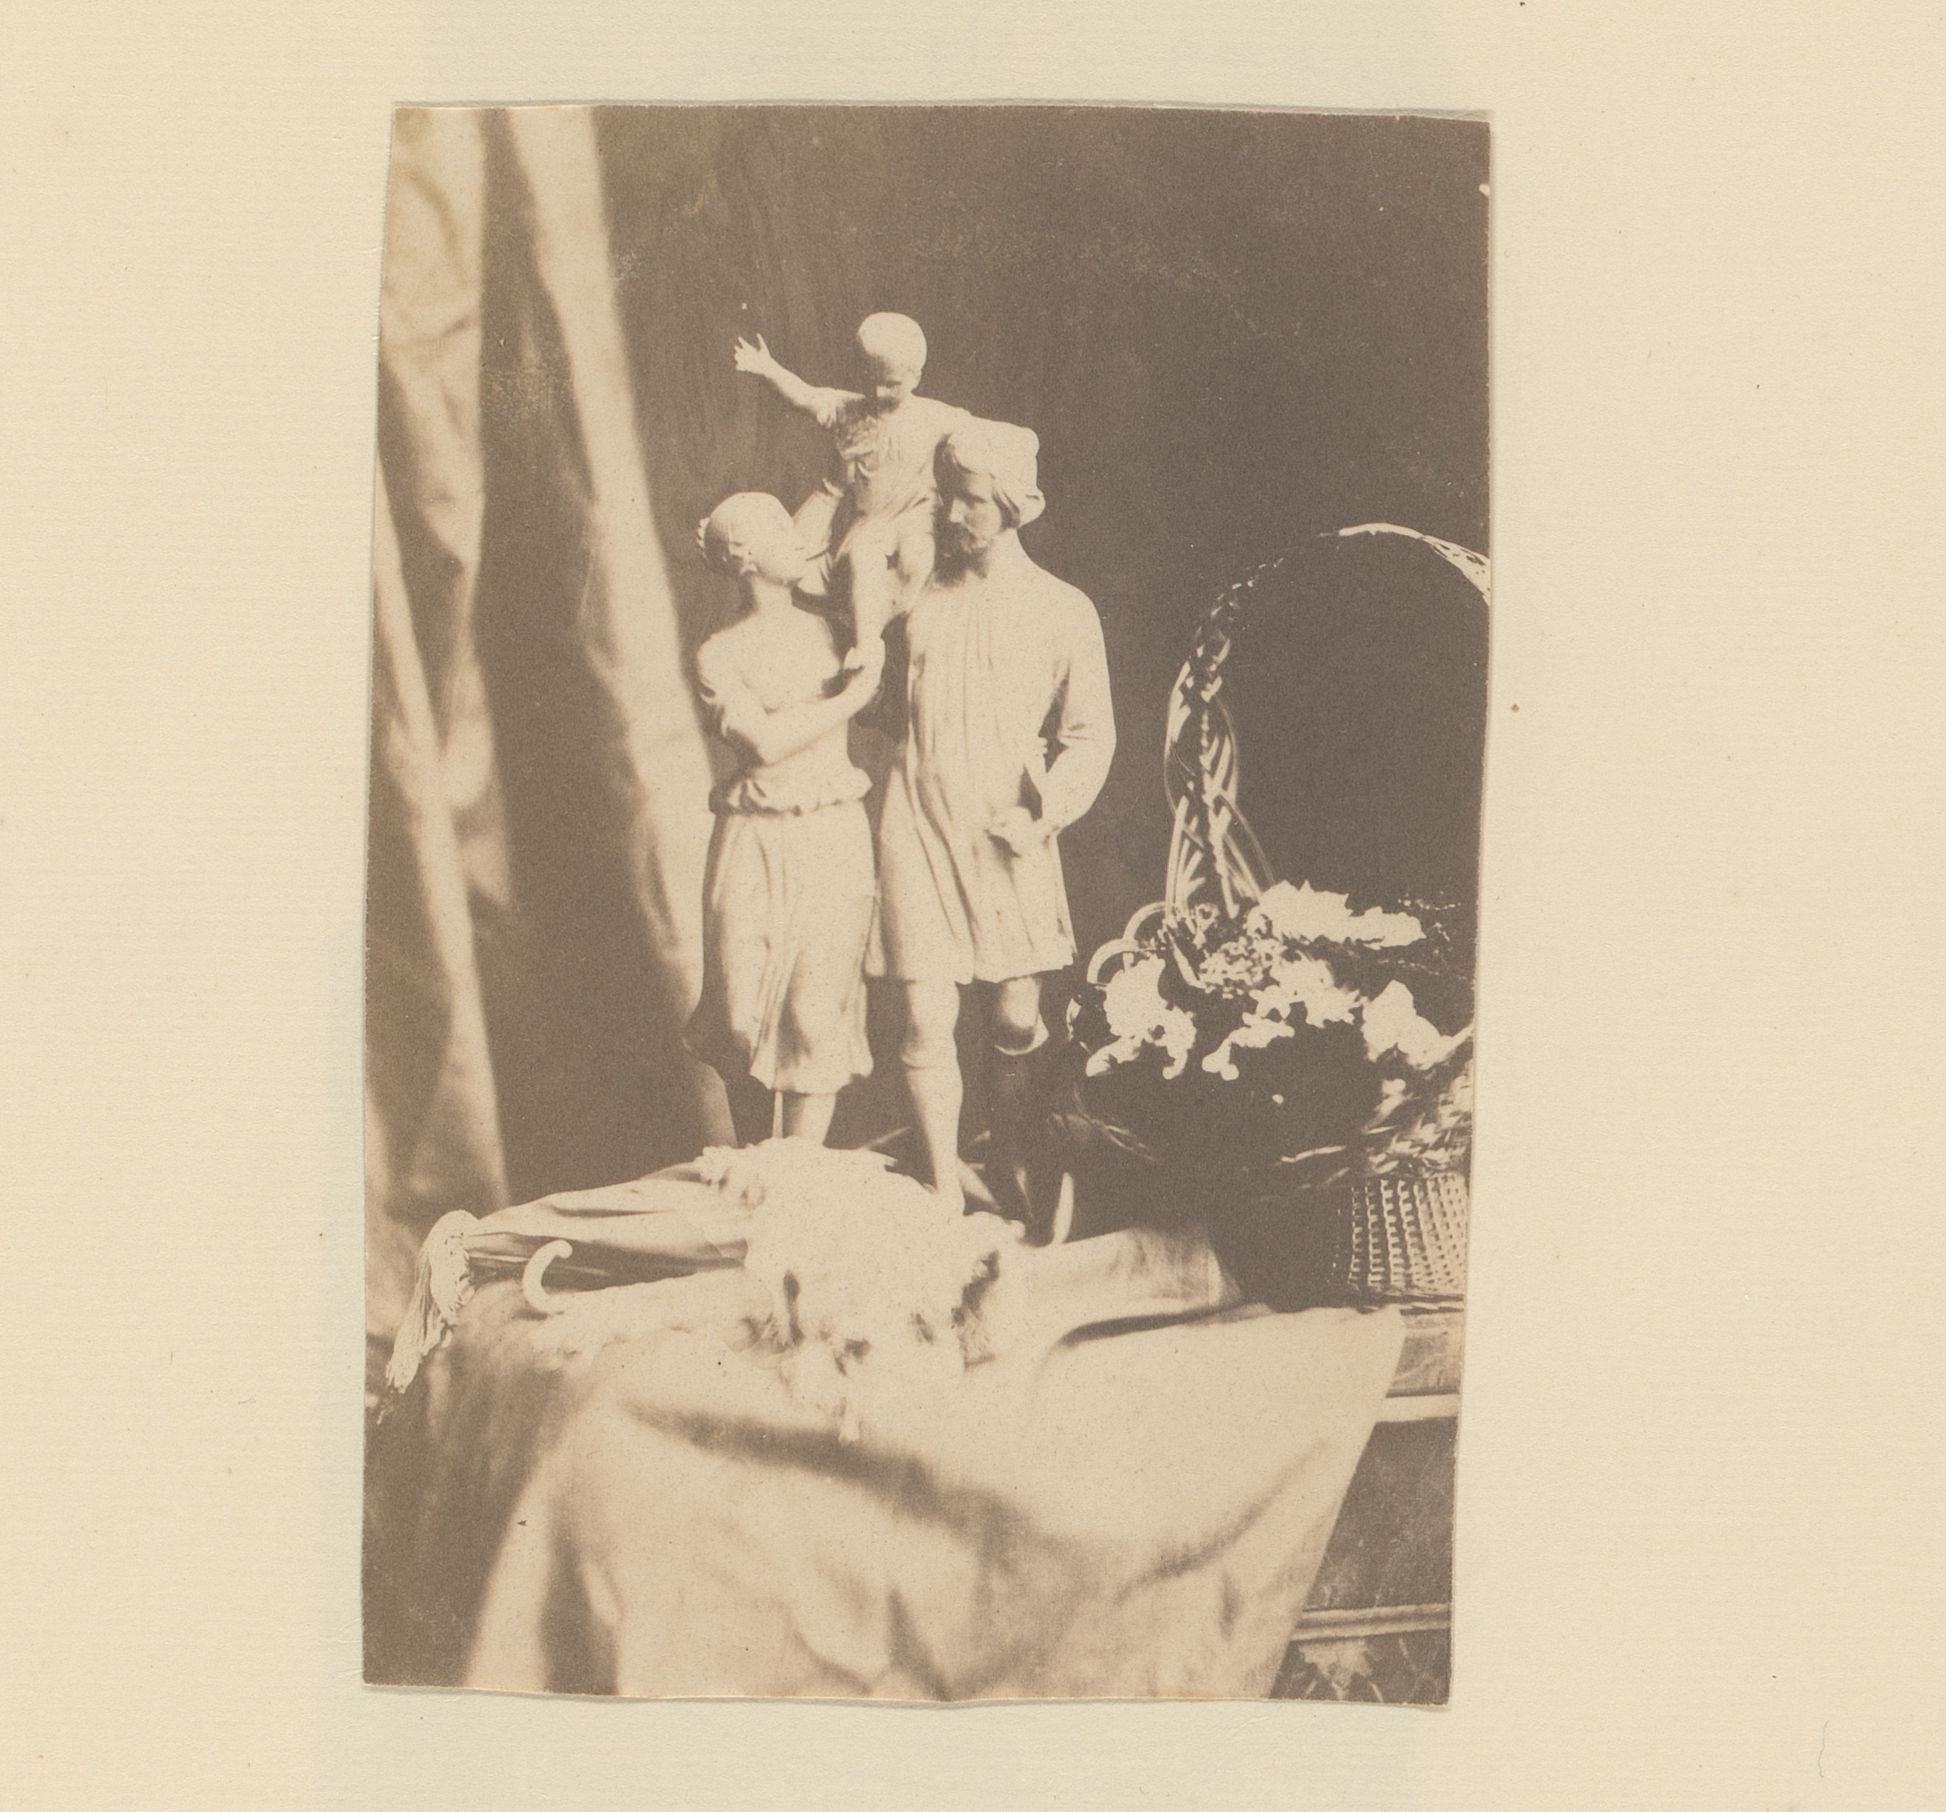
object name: photograph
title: Stilleven met statuette en mand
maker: eduard isaac asser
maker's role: amateurfotograaf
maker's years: 1809-1894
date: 1852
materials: cardboard, paper, photographic support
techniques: salted paper print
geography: amsterdam